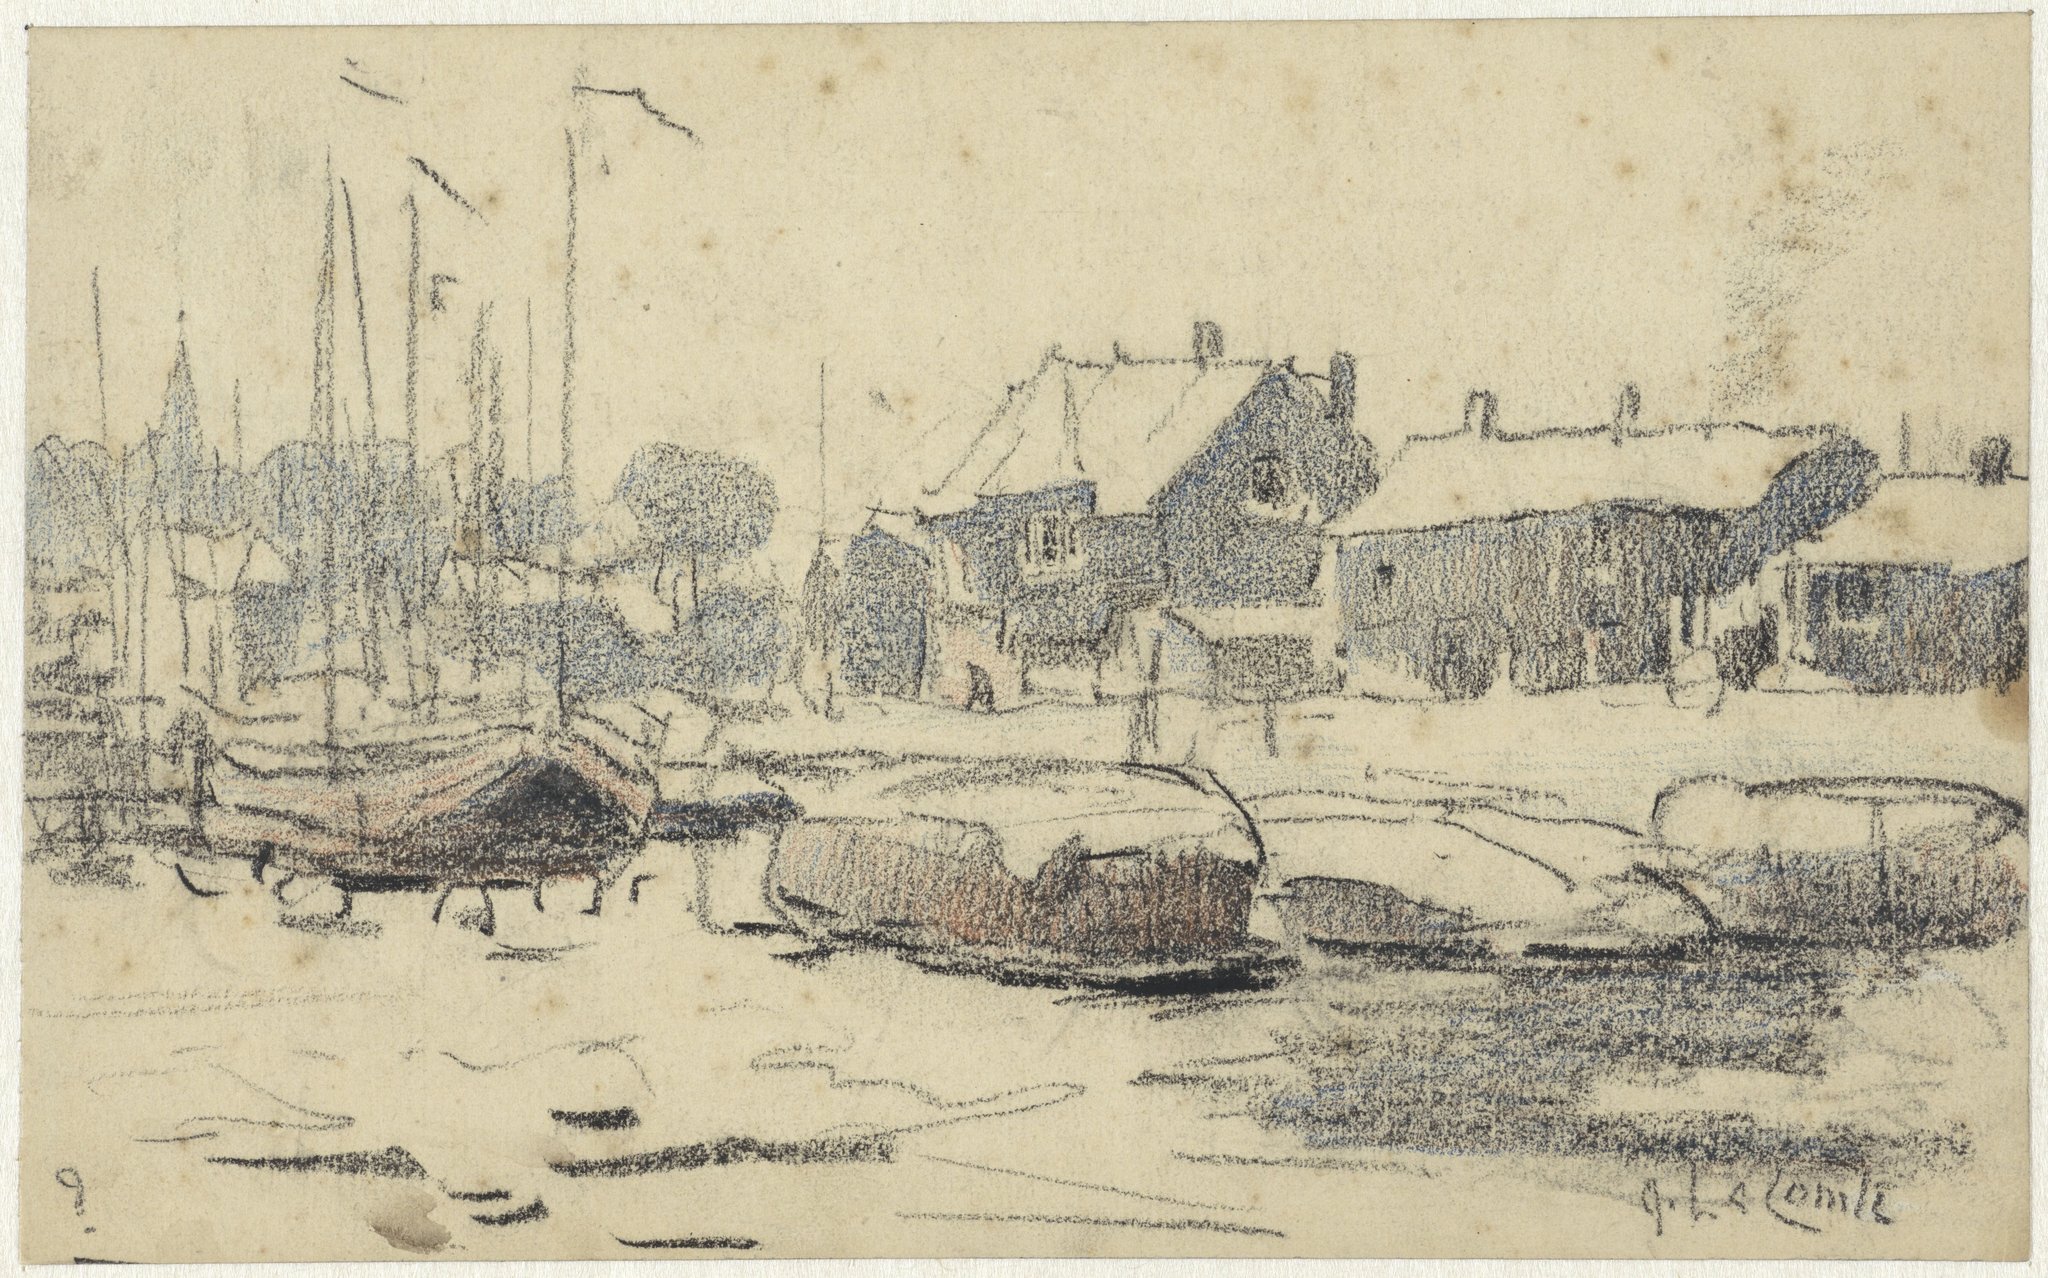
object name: drawing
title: Haventje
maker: adolf le comte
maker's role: draughtsman, painter, print maker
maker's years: 1850-1921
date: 1860-1921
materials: chalk, paper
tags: harbour